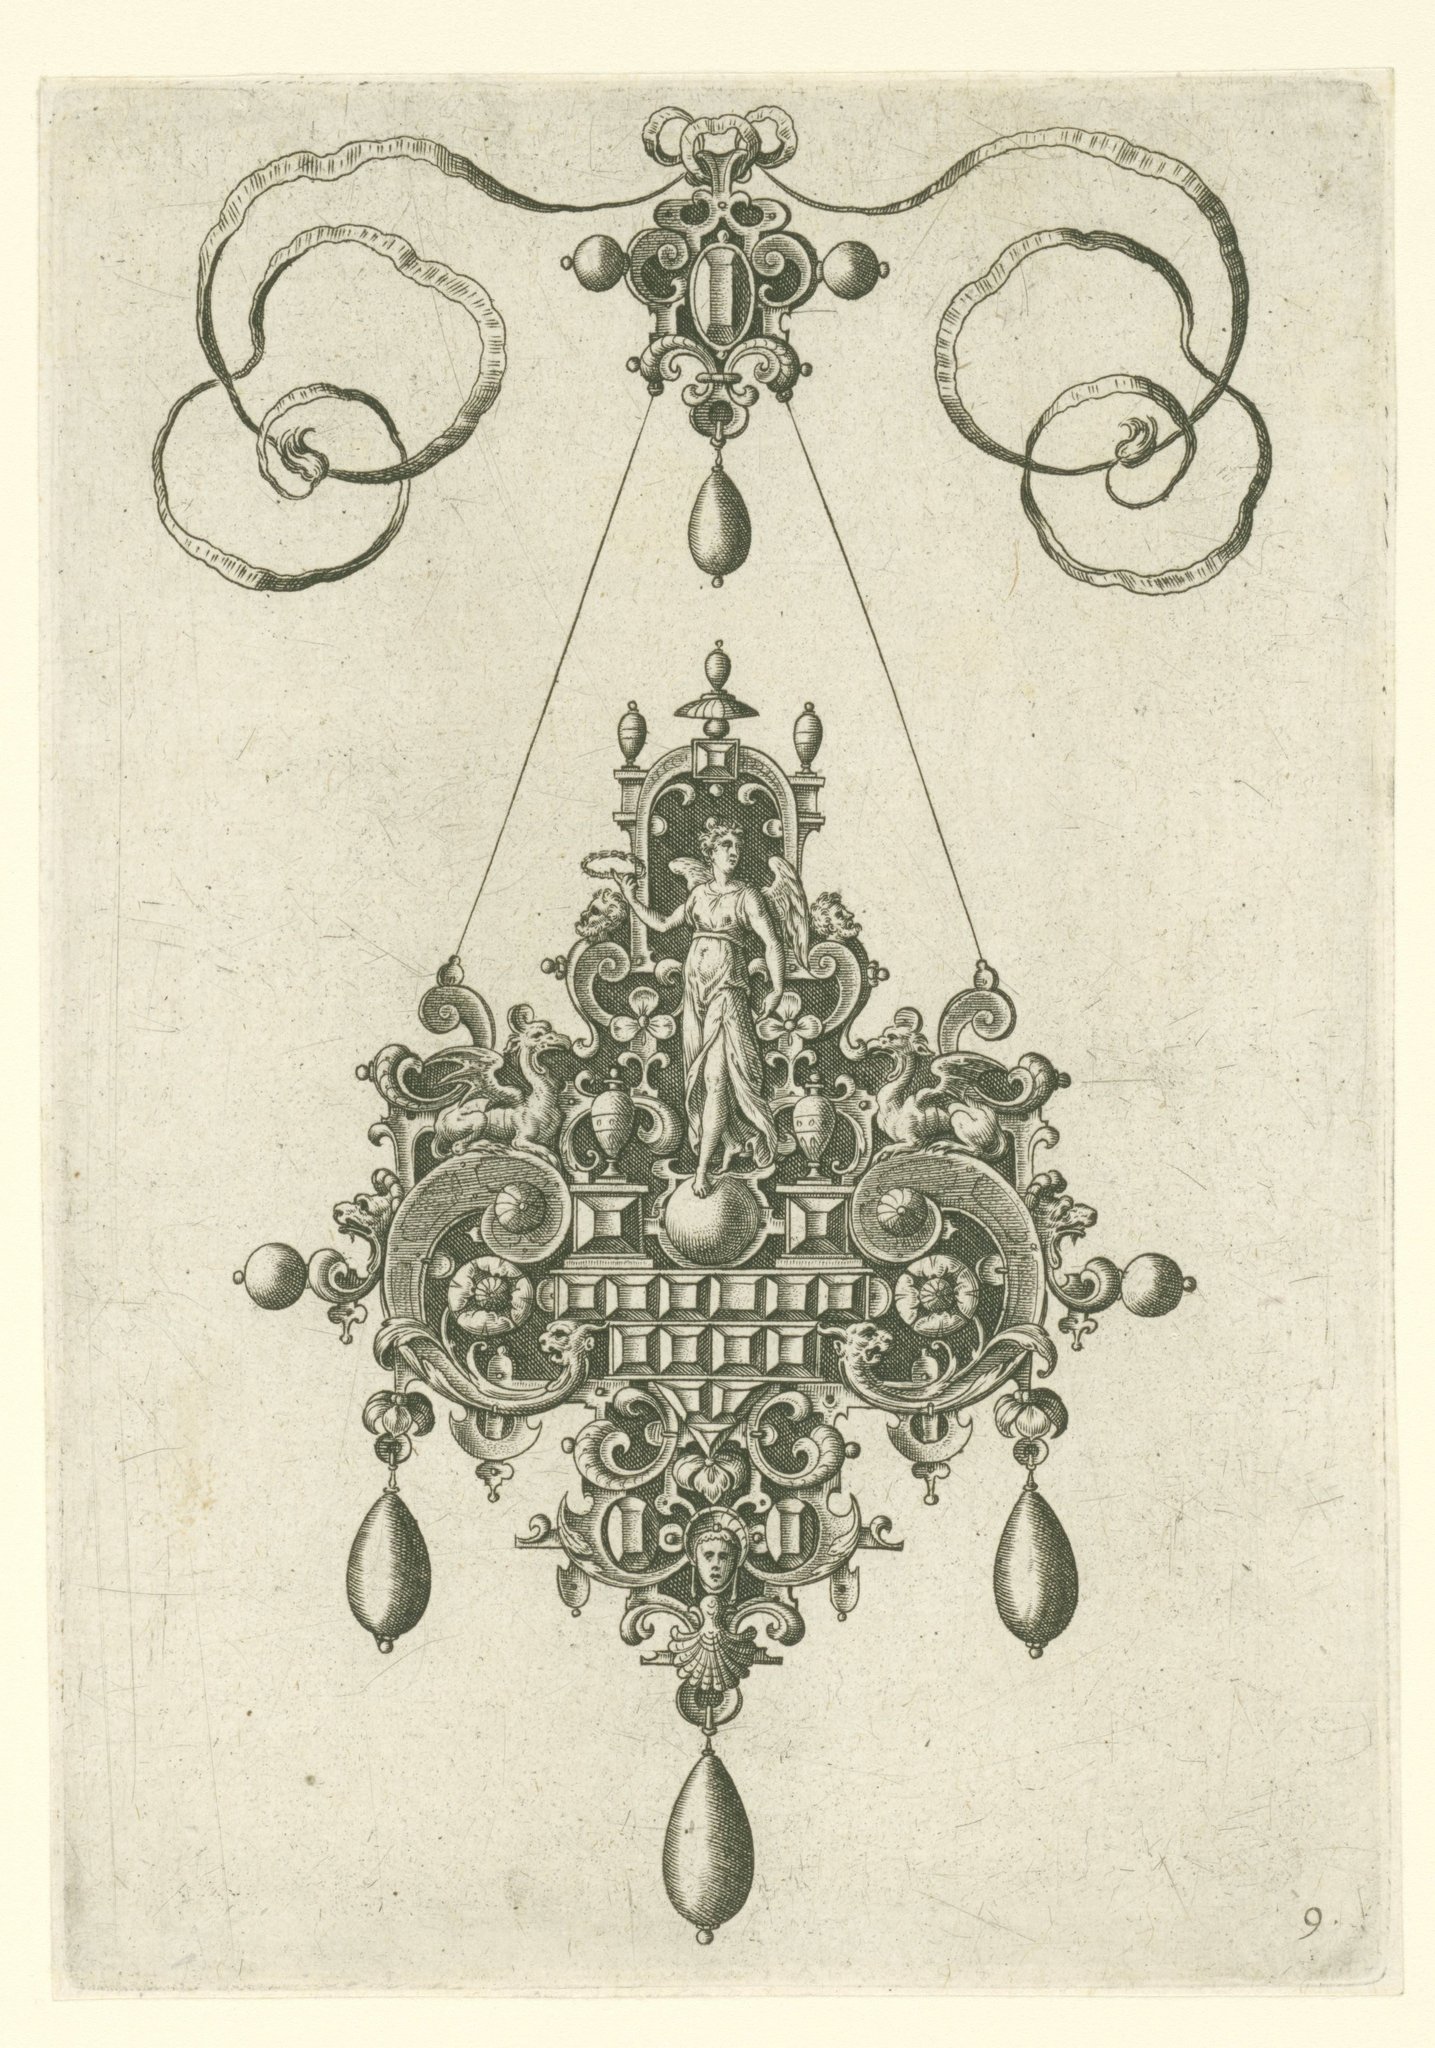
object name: ornament print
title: Hanger met Victoria, laurierkrans in de hand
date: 1581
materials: paper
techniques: engraving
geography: netherlands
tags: pendant, trinket, 'breloque', victory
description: No. 9 uit serie van 10 bladen met ornamentontwerpen voor voorzijden van hangers, Antwerpen 1581. W. 20